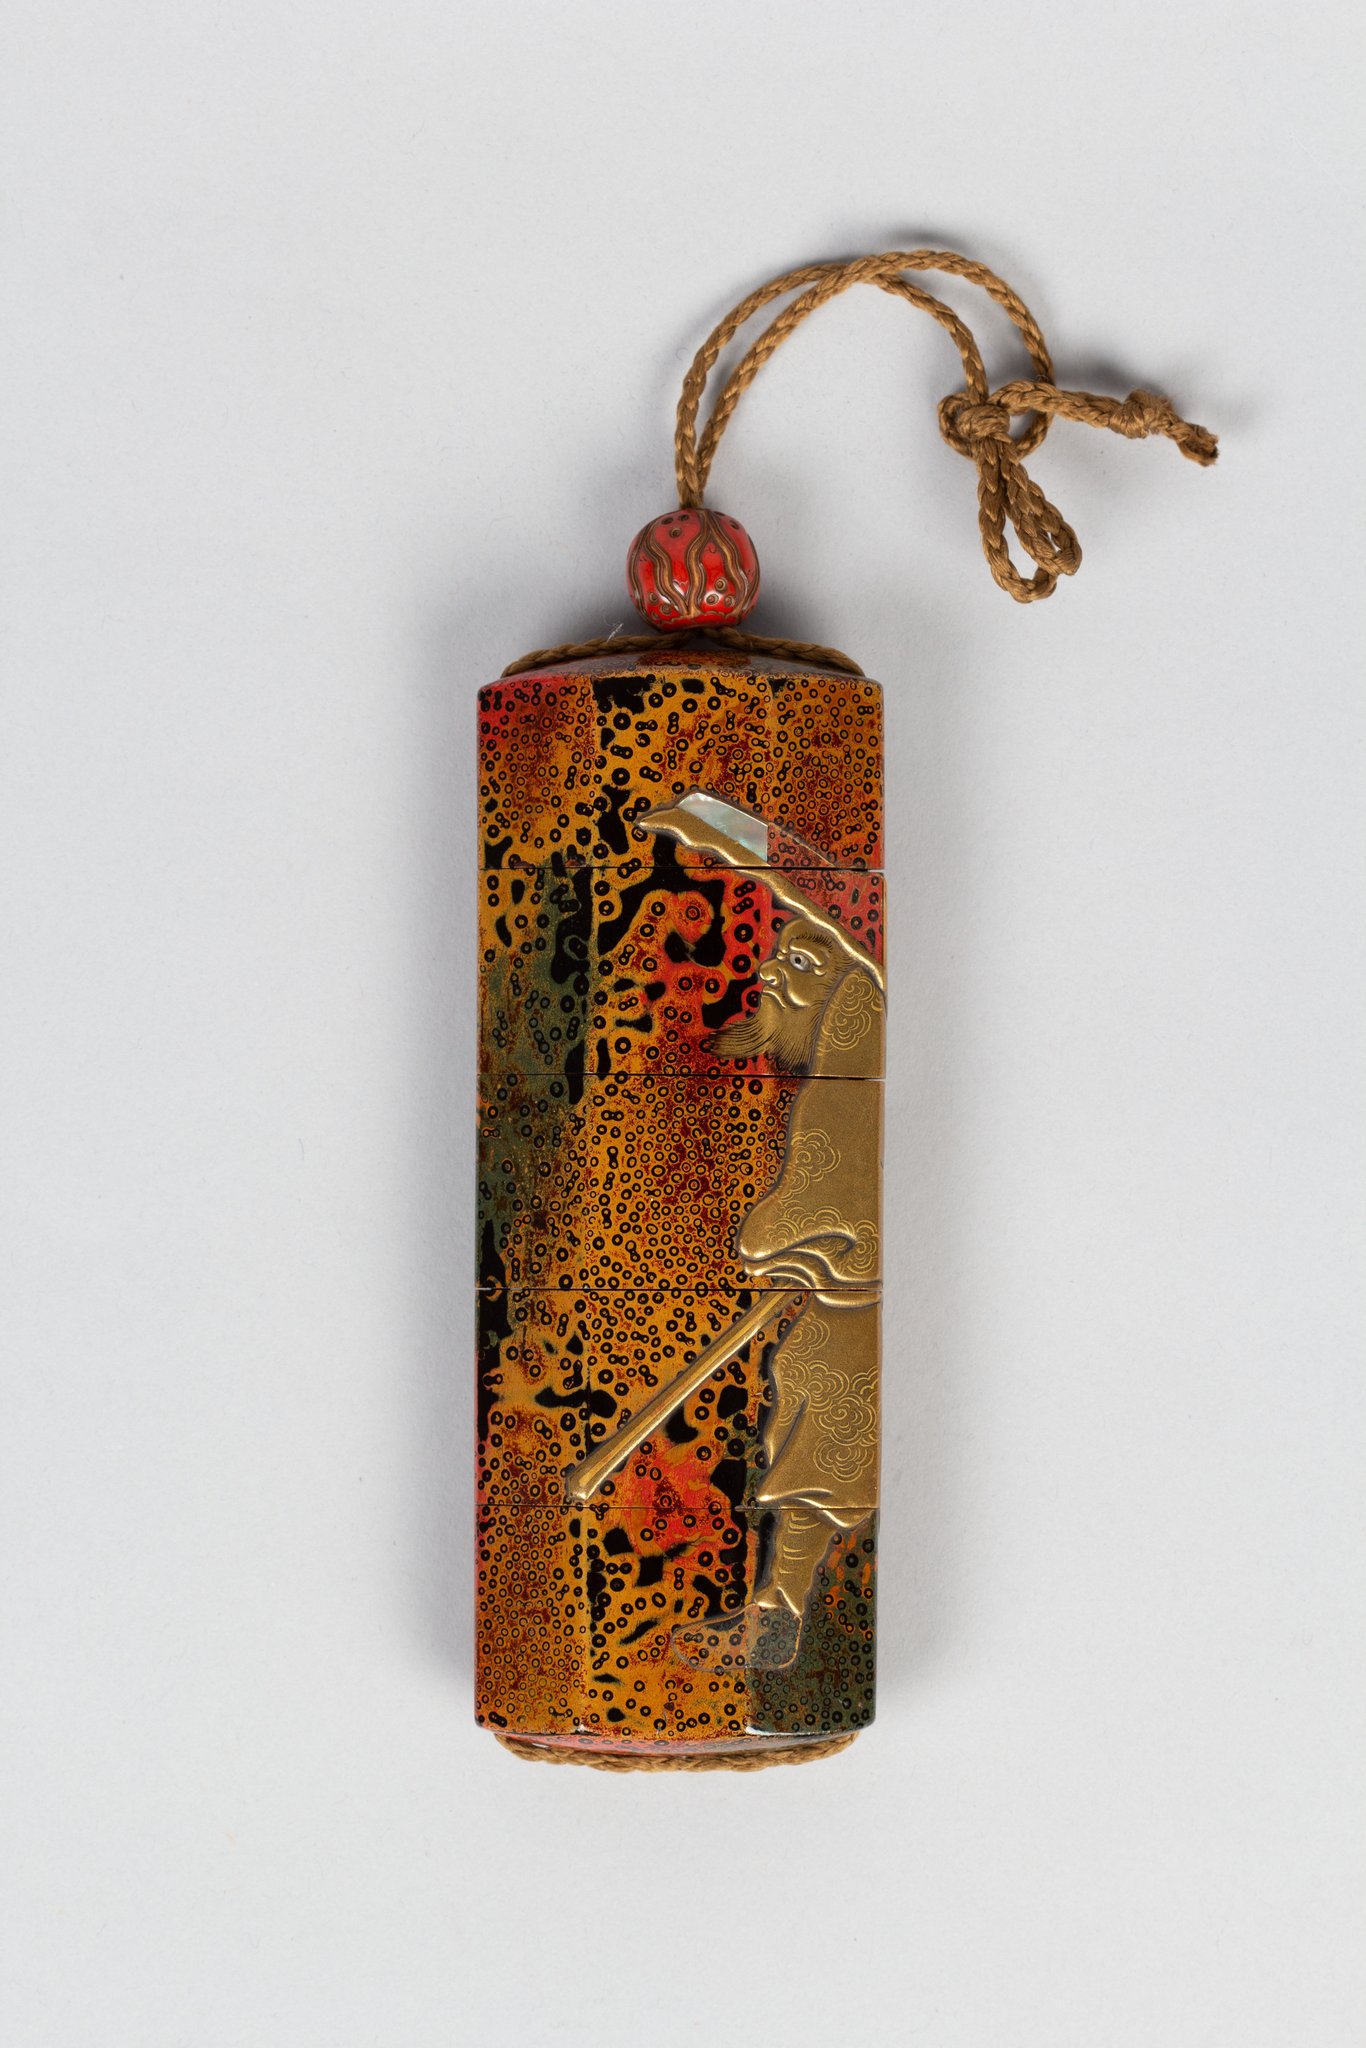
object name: inrō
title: Case (Inrō) with Design of Shoki with Wide Hat and Sword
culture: japanese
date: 1701-1900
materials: gold, lacquer, silver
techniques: fundame, hiramakie, roiro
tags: swords,men